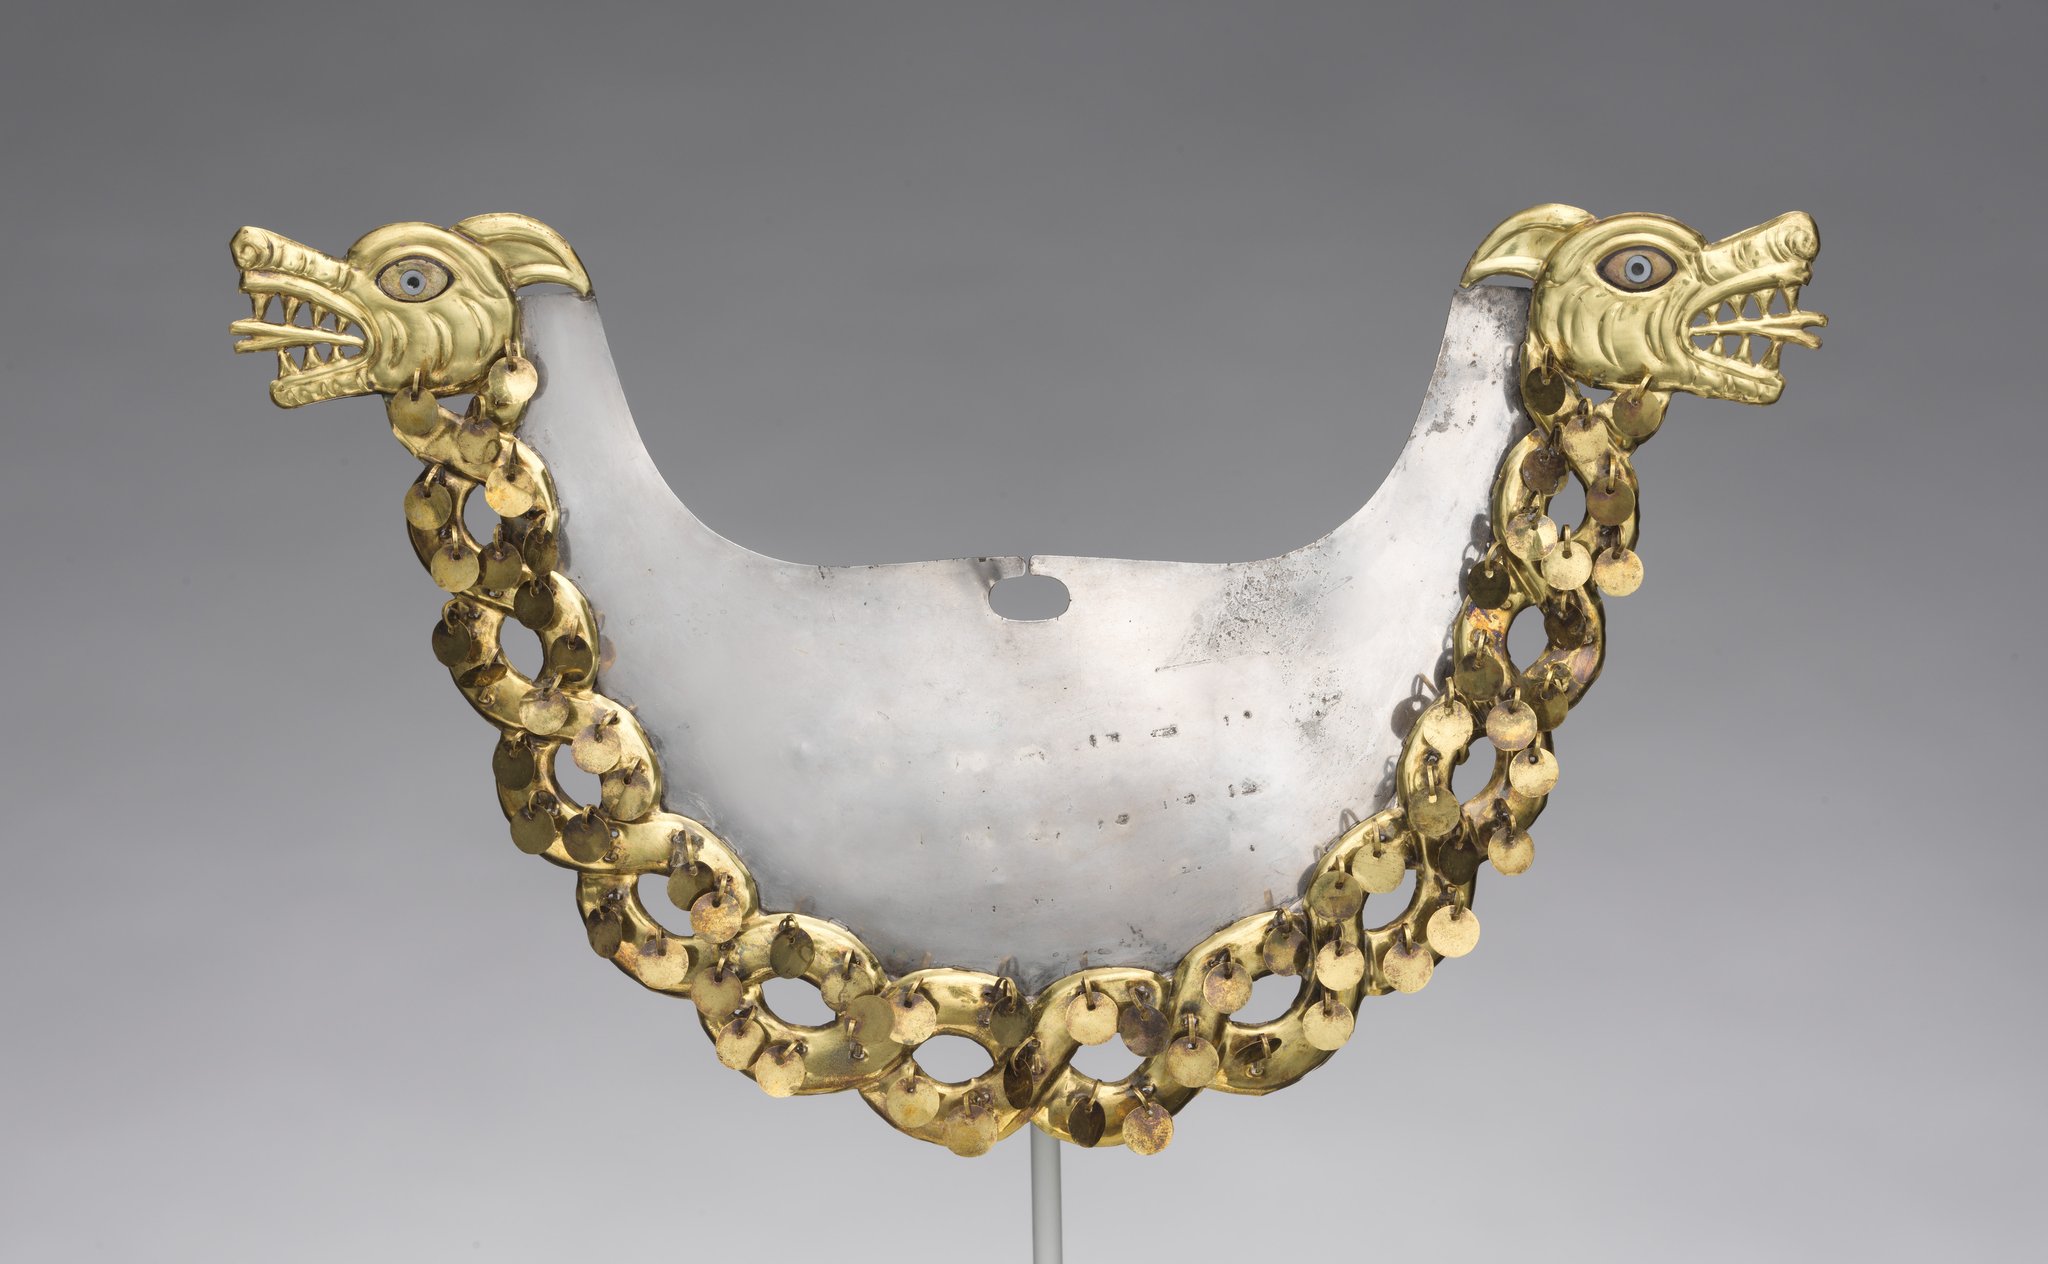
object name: nose ornament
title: Nose ornament with intertwined creatures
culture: moche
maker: moche artist(s)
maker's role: artist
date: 500-800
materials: gold, silver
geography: peru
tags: serpents